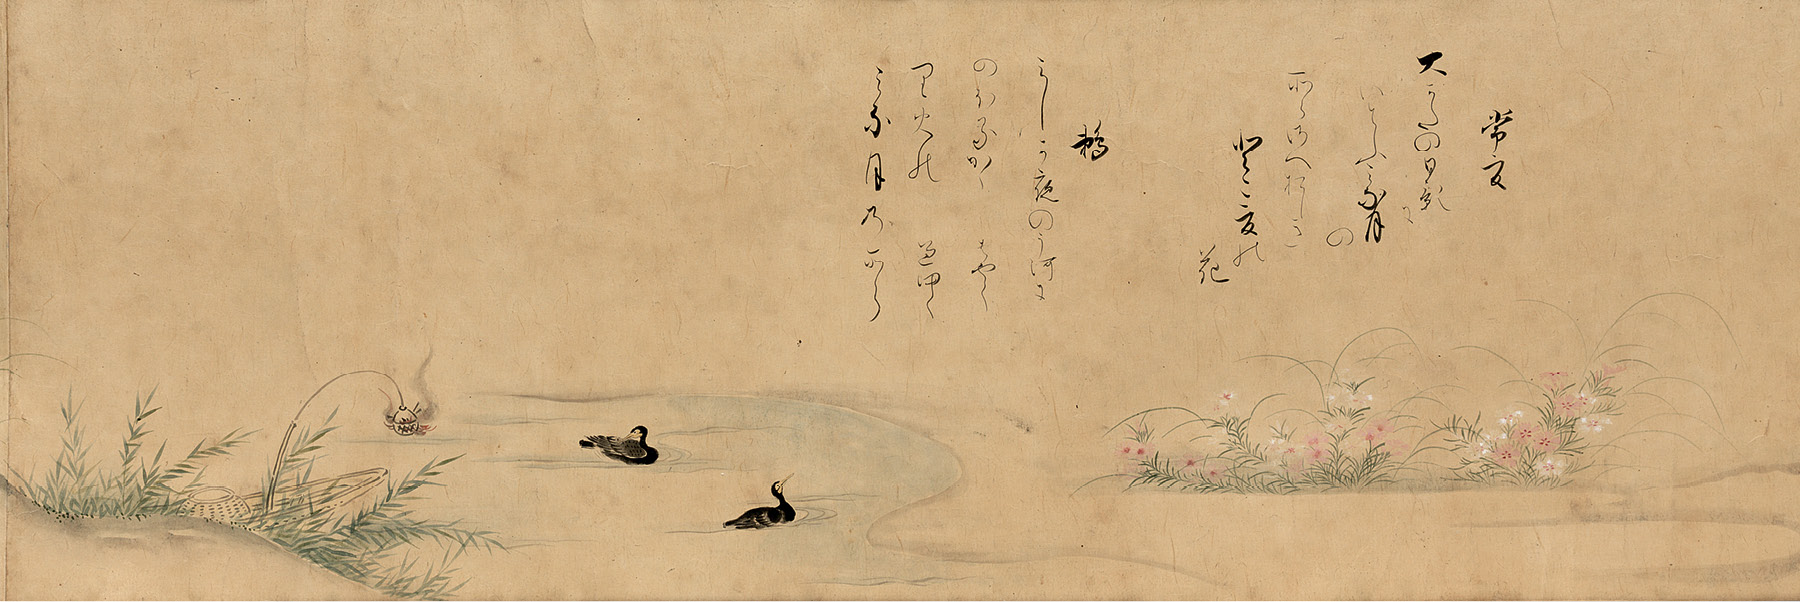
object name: handscroll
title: Fujiwara no Teika’s “Poems on Flowers and Birds of the Twelve Months”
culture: japanese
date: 1701-1800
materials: ink, paper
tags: birds